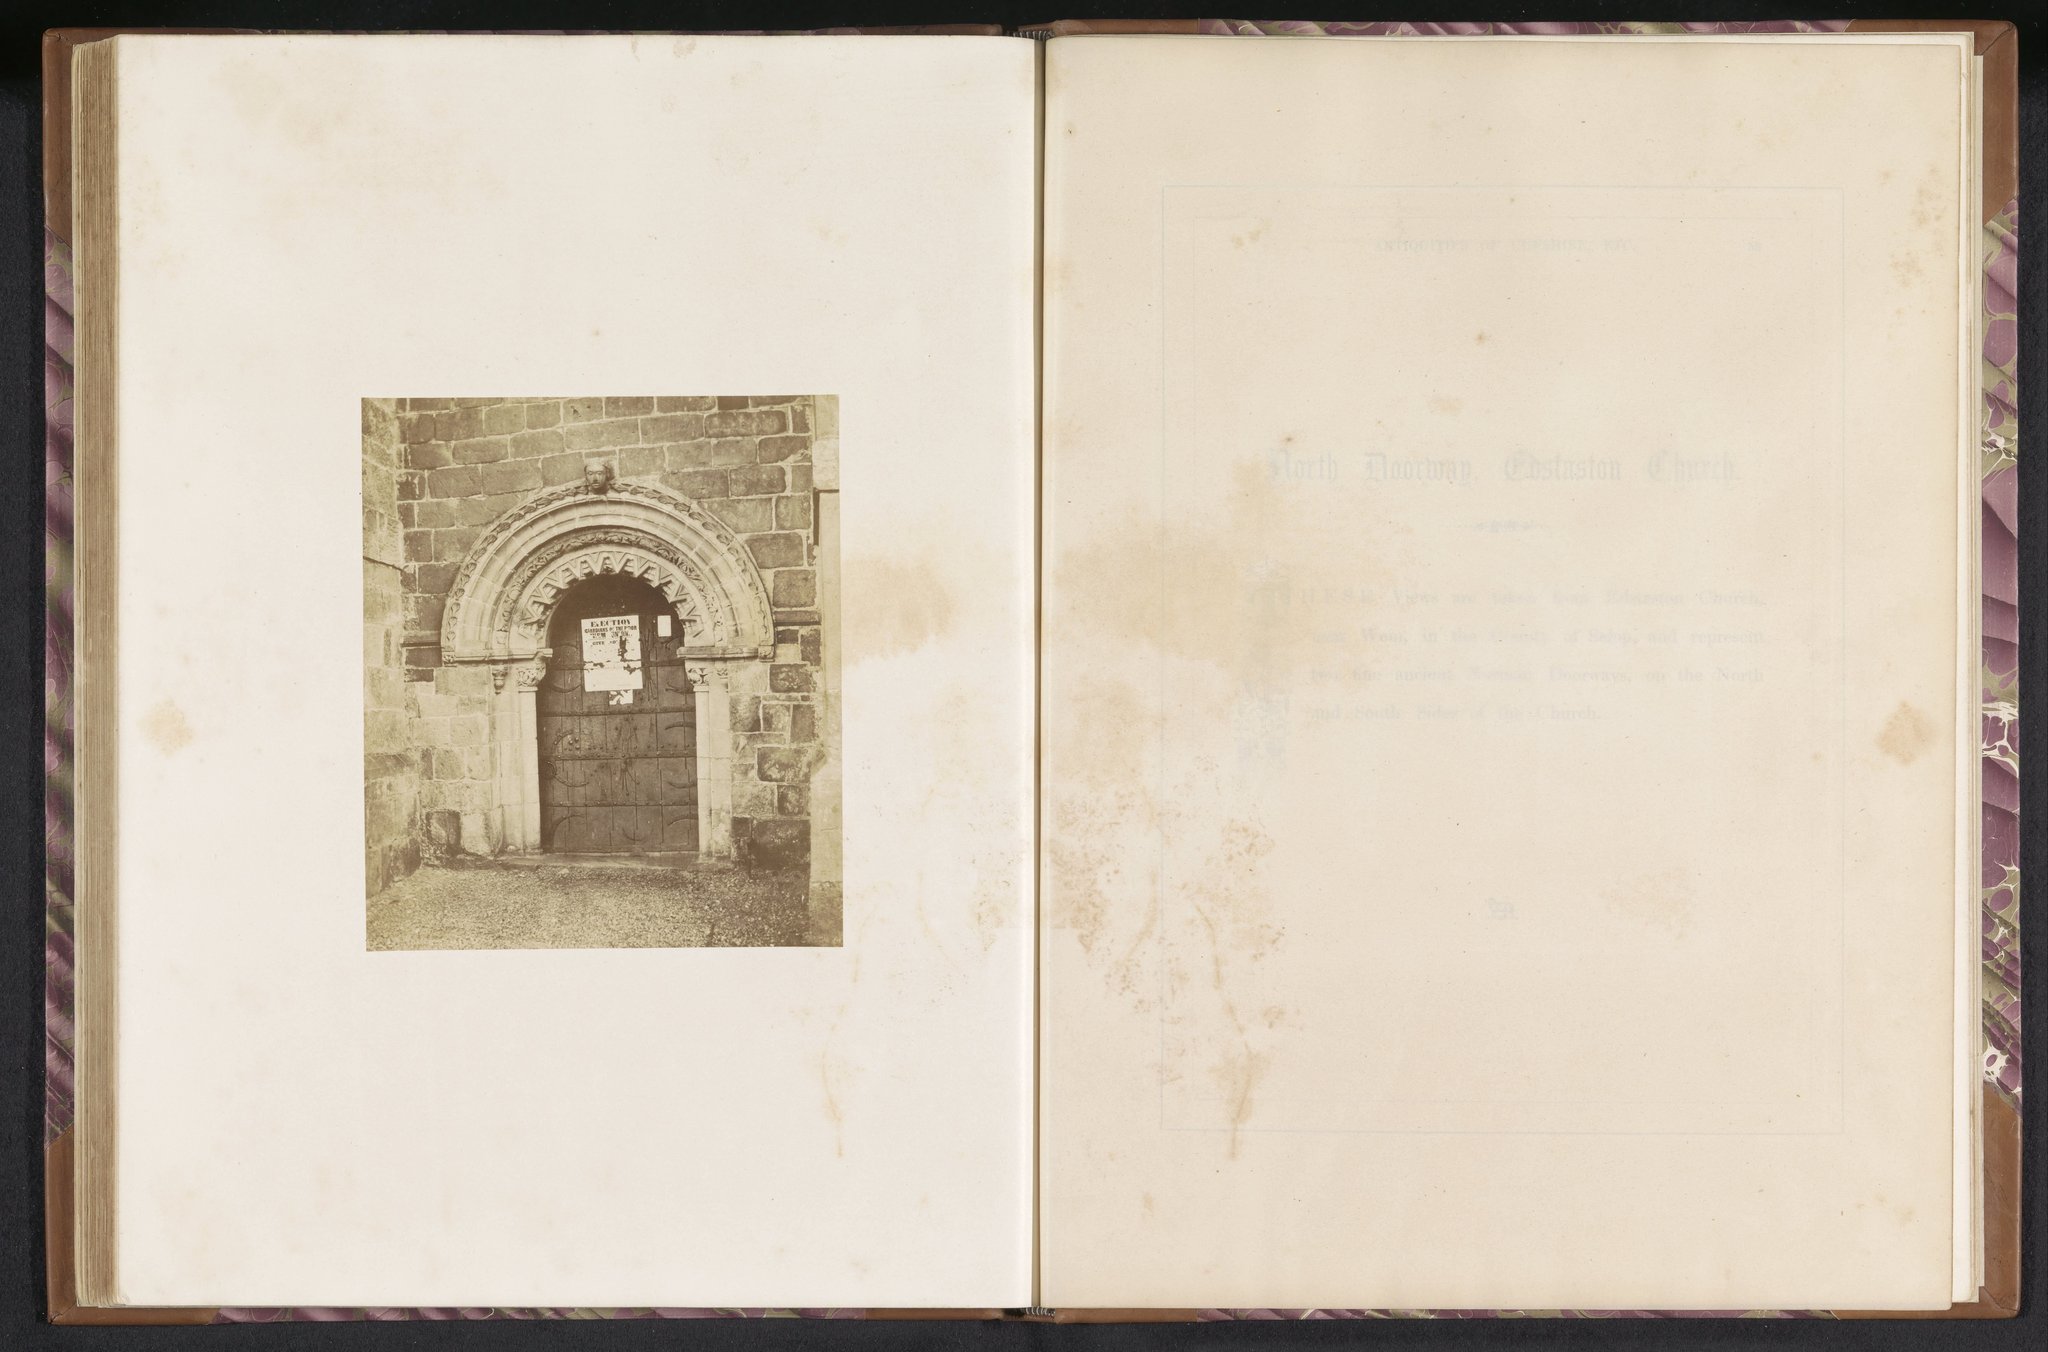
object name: photograph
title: North Doorway, Edstaston Church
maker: william bryans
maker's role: fotograaf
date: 1850-1858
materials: photographic support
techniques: albumen print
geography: edstaston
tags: parts of church exterior and annexes: portal, church (exterior)